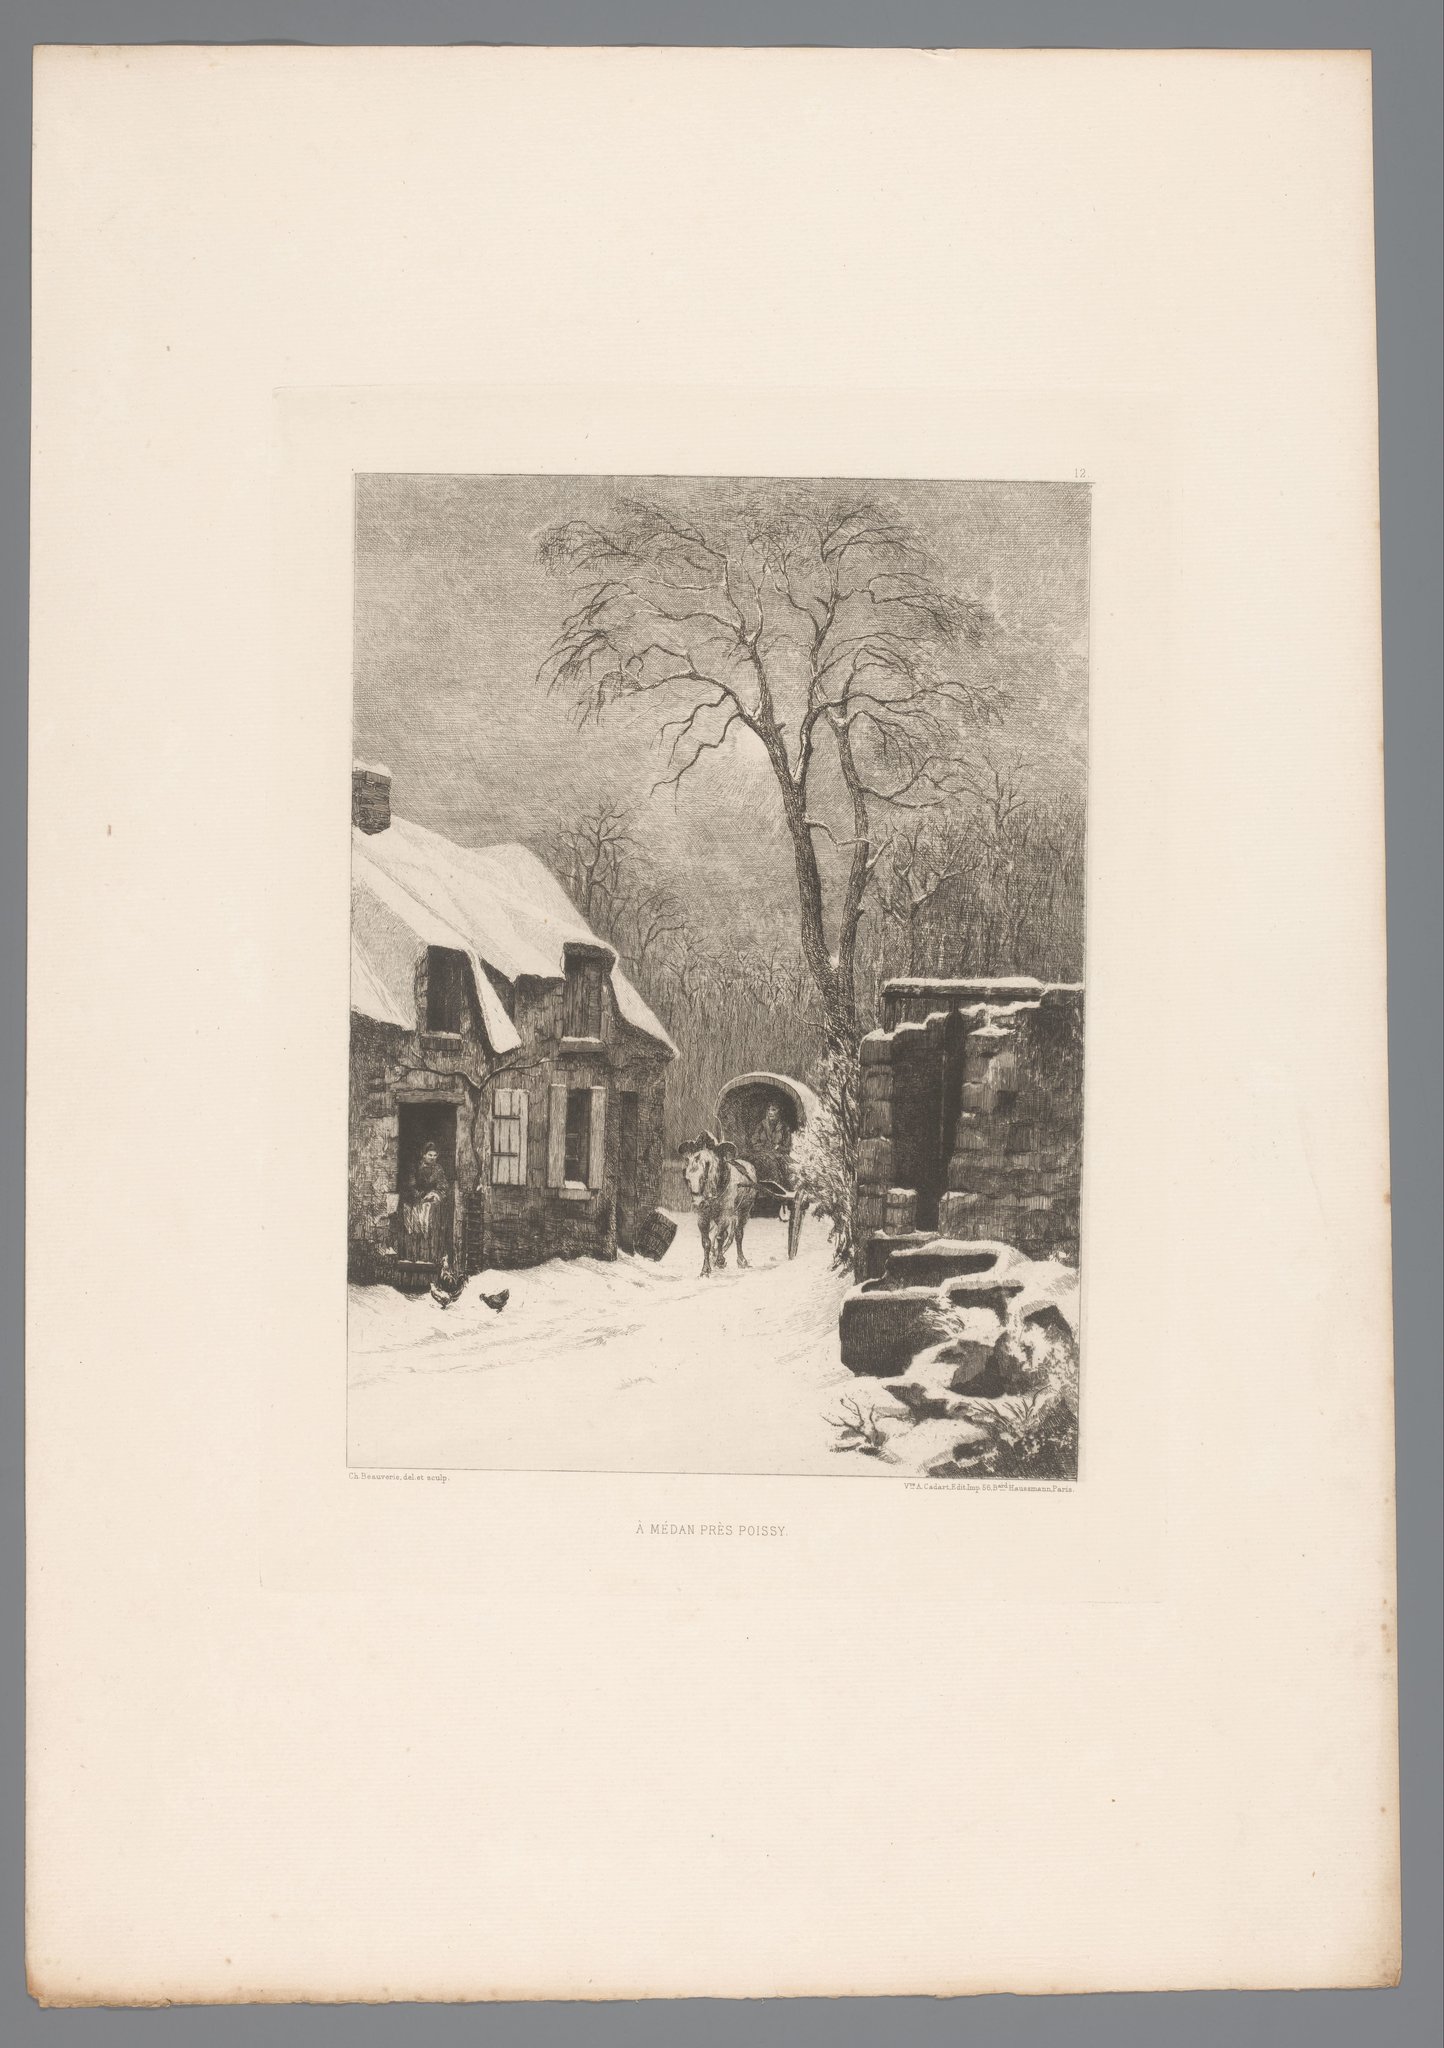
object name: print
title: L'eau-forte en 1876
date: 1876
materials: paper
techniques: drypoint, etching, intaglio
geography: paris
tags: village, snow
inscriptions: collector's mark: Lugt 2760, collector's mark: Lugt 2228, watermark, collector's mark: ‘AFE v S’